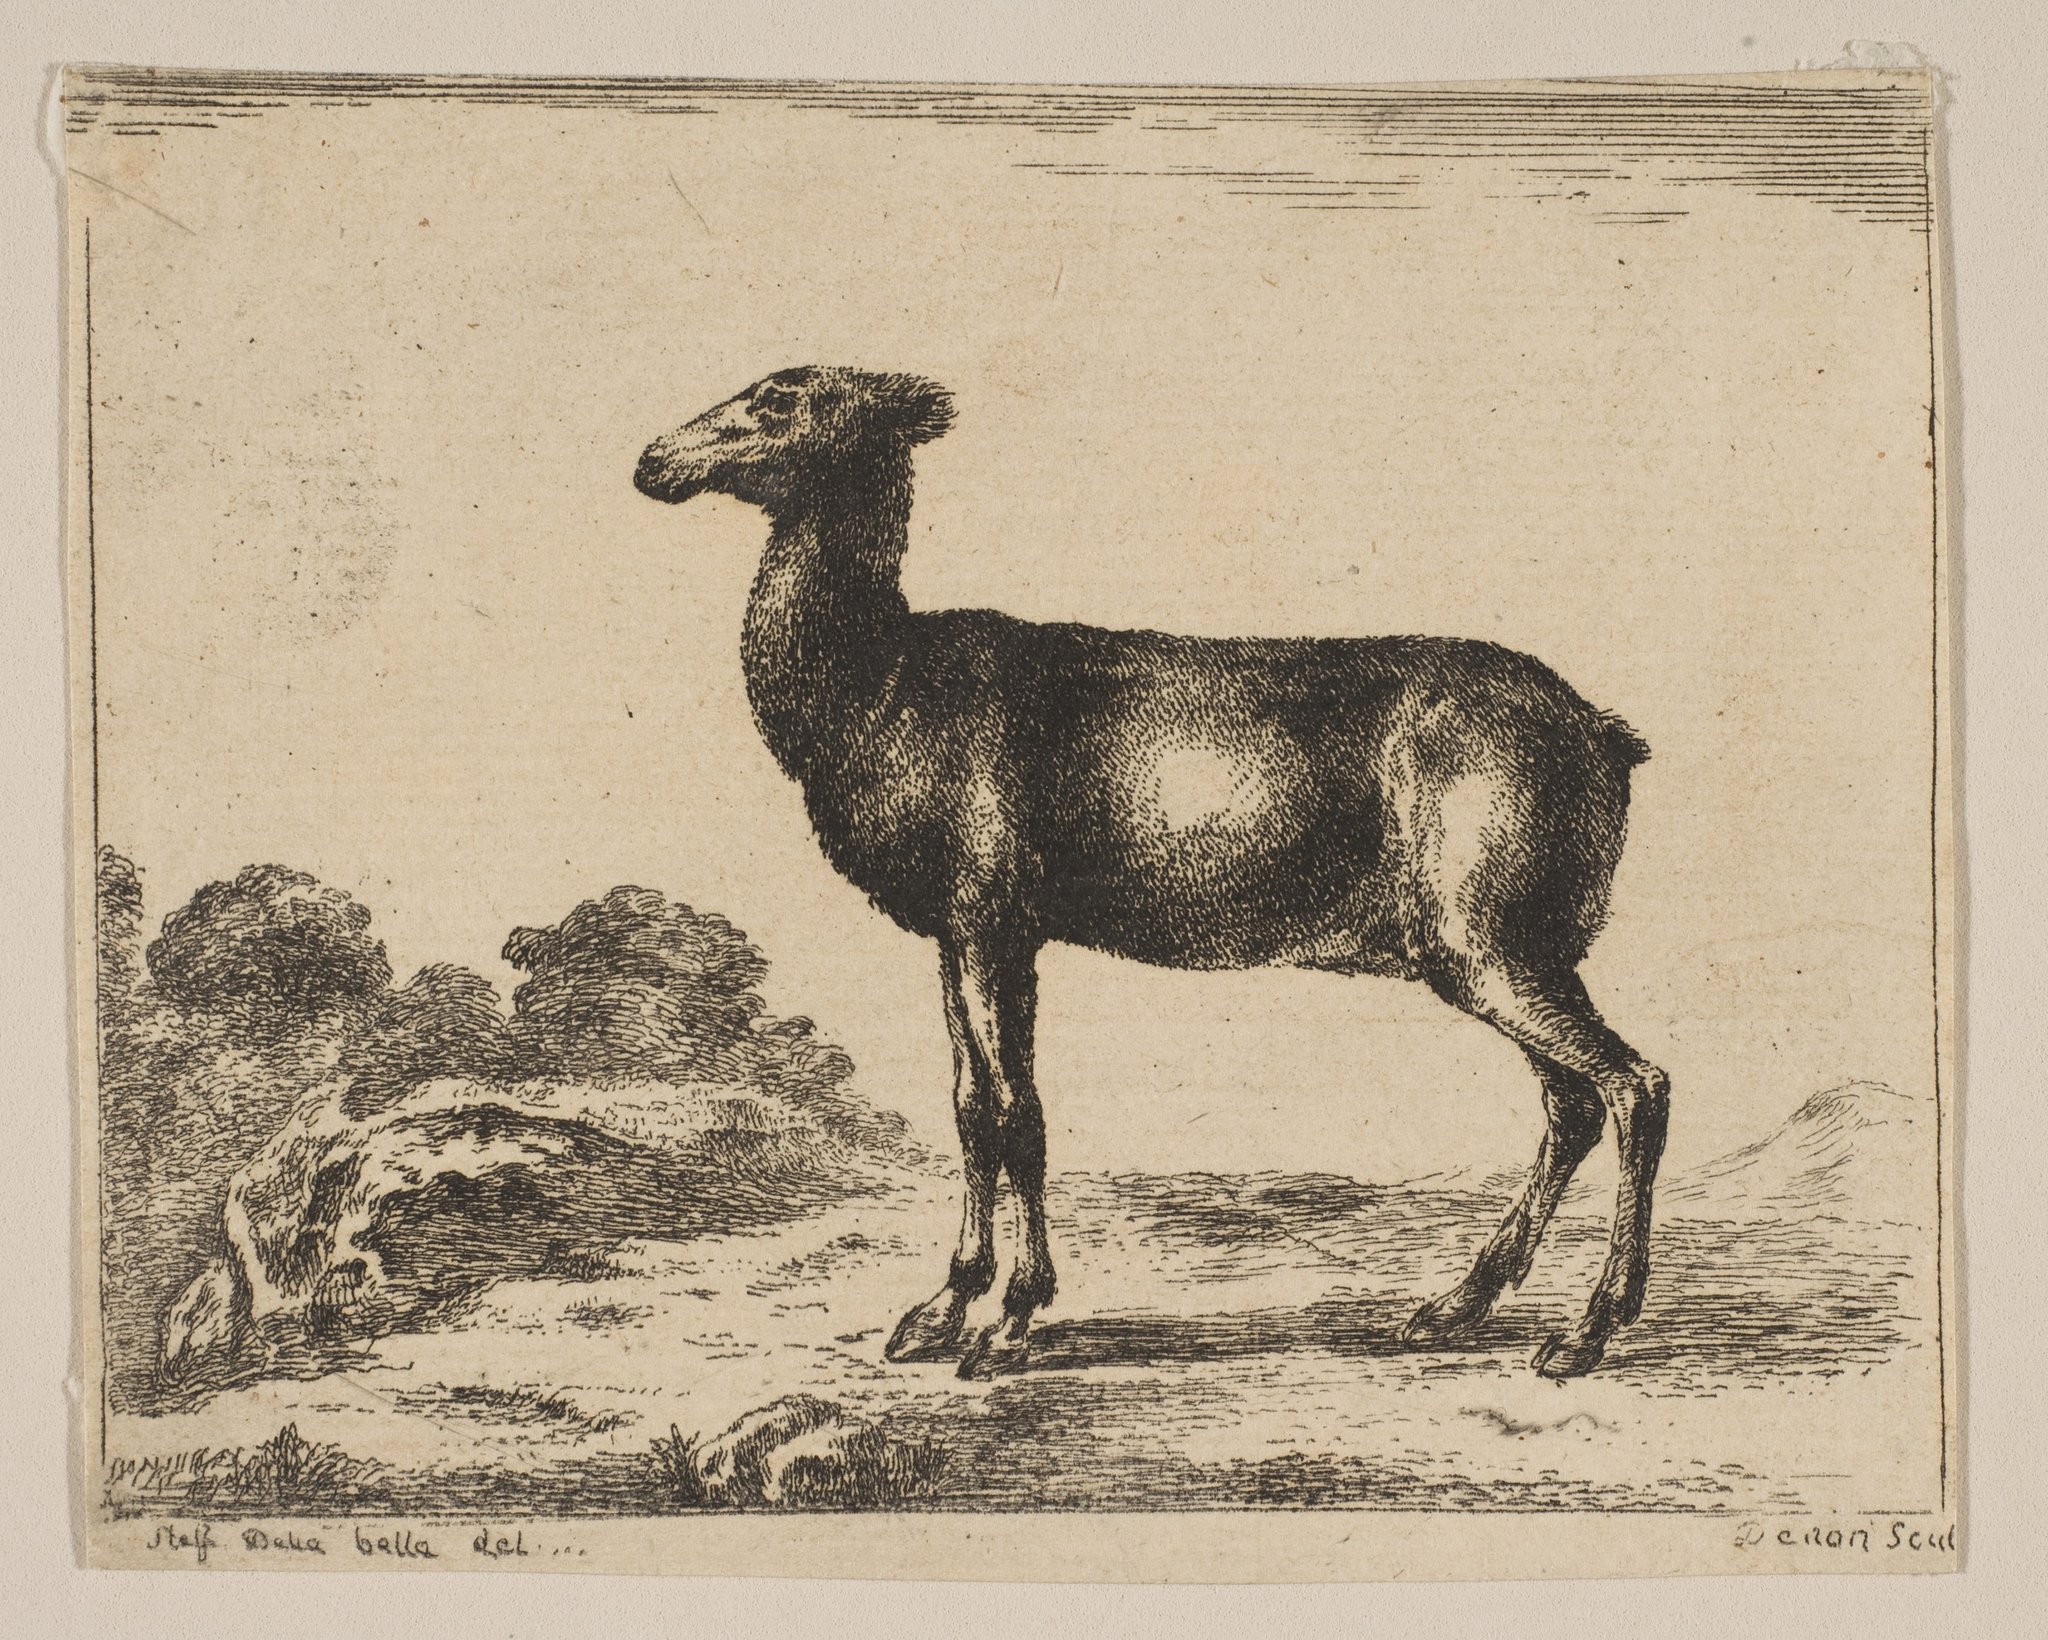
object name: print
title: Plate 15: doe, from 'Various animals' (Diversi animali)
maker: anonymous, 17th century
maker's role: printmaker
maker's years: 1600-1700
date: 1641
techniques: etching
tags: deer